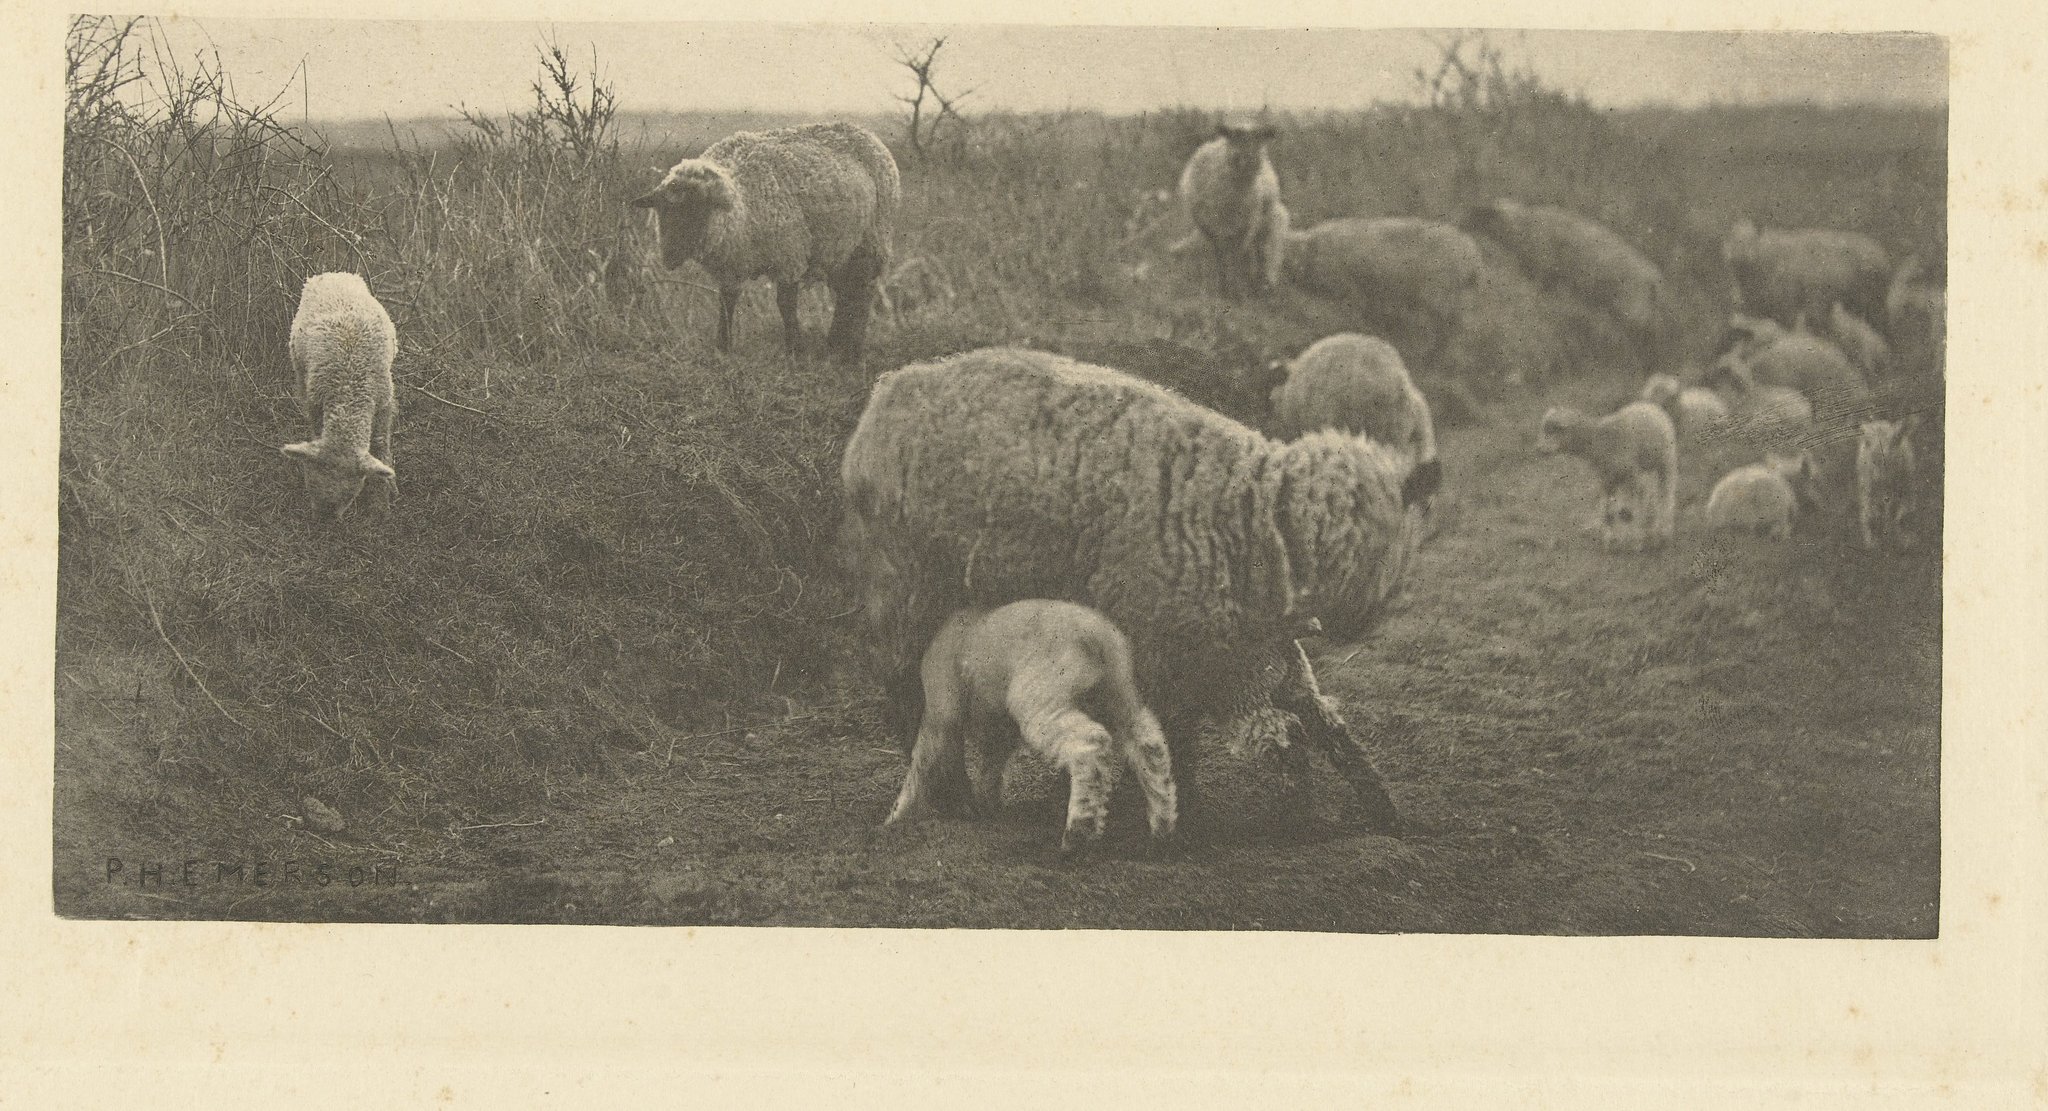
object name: photomechanical print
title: A Marsh Pastorale (Suffolk)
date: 1883-1888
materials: paper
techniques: photoaquatint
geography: great britain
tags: sheep